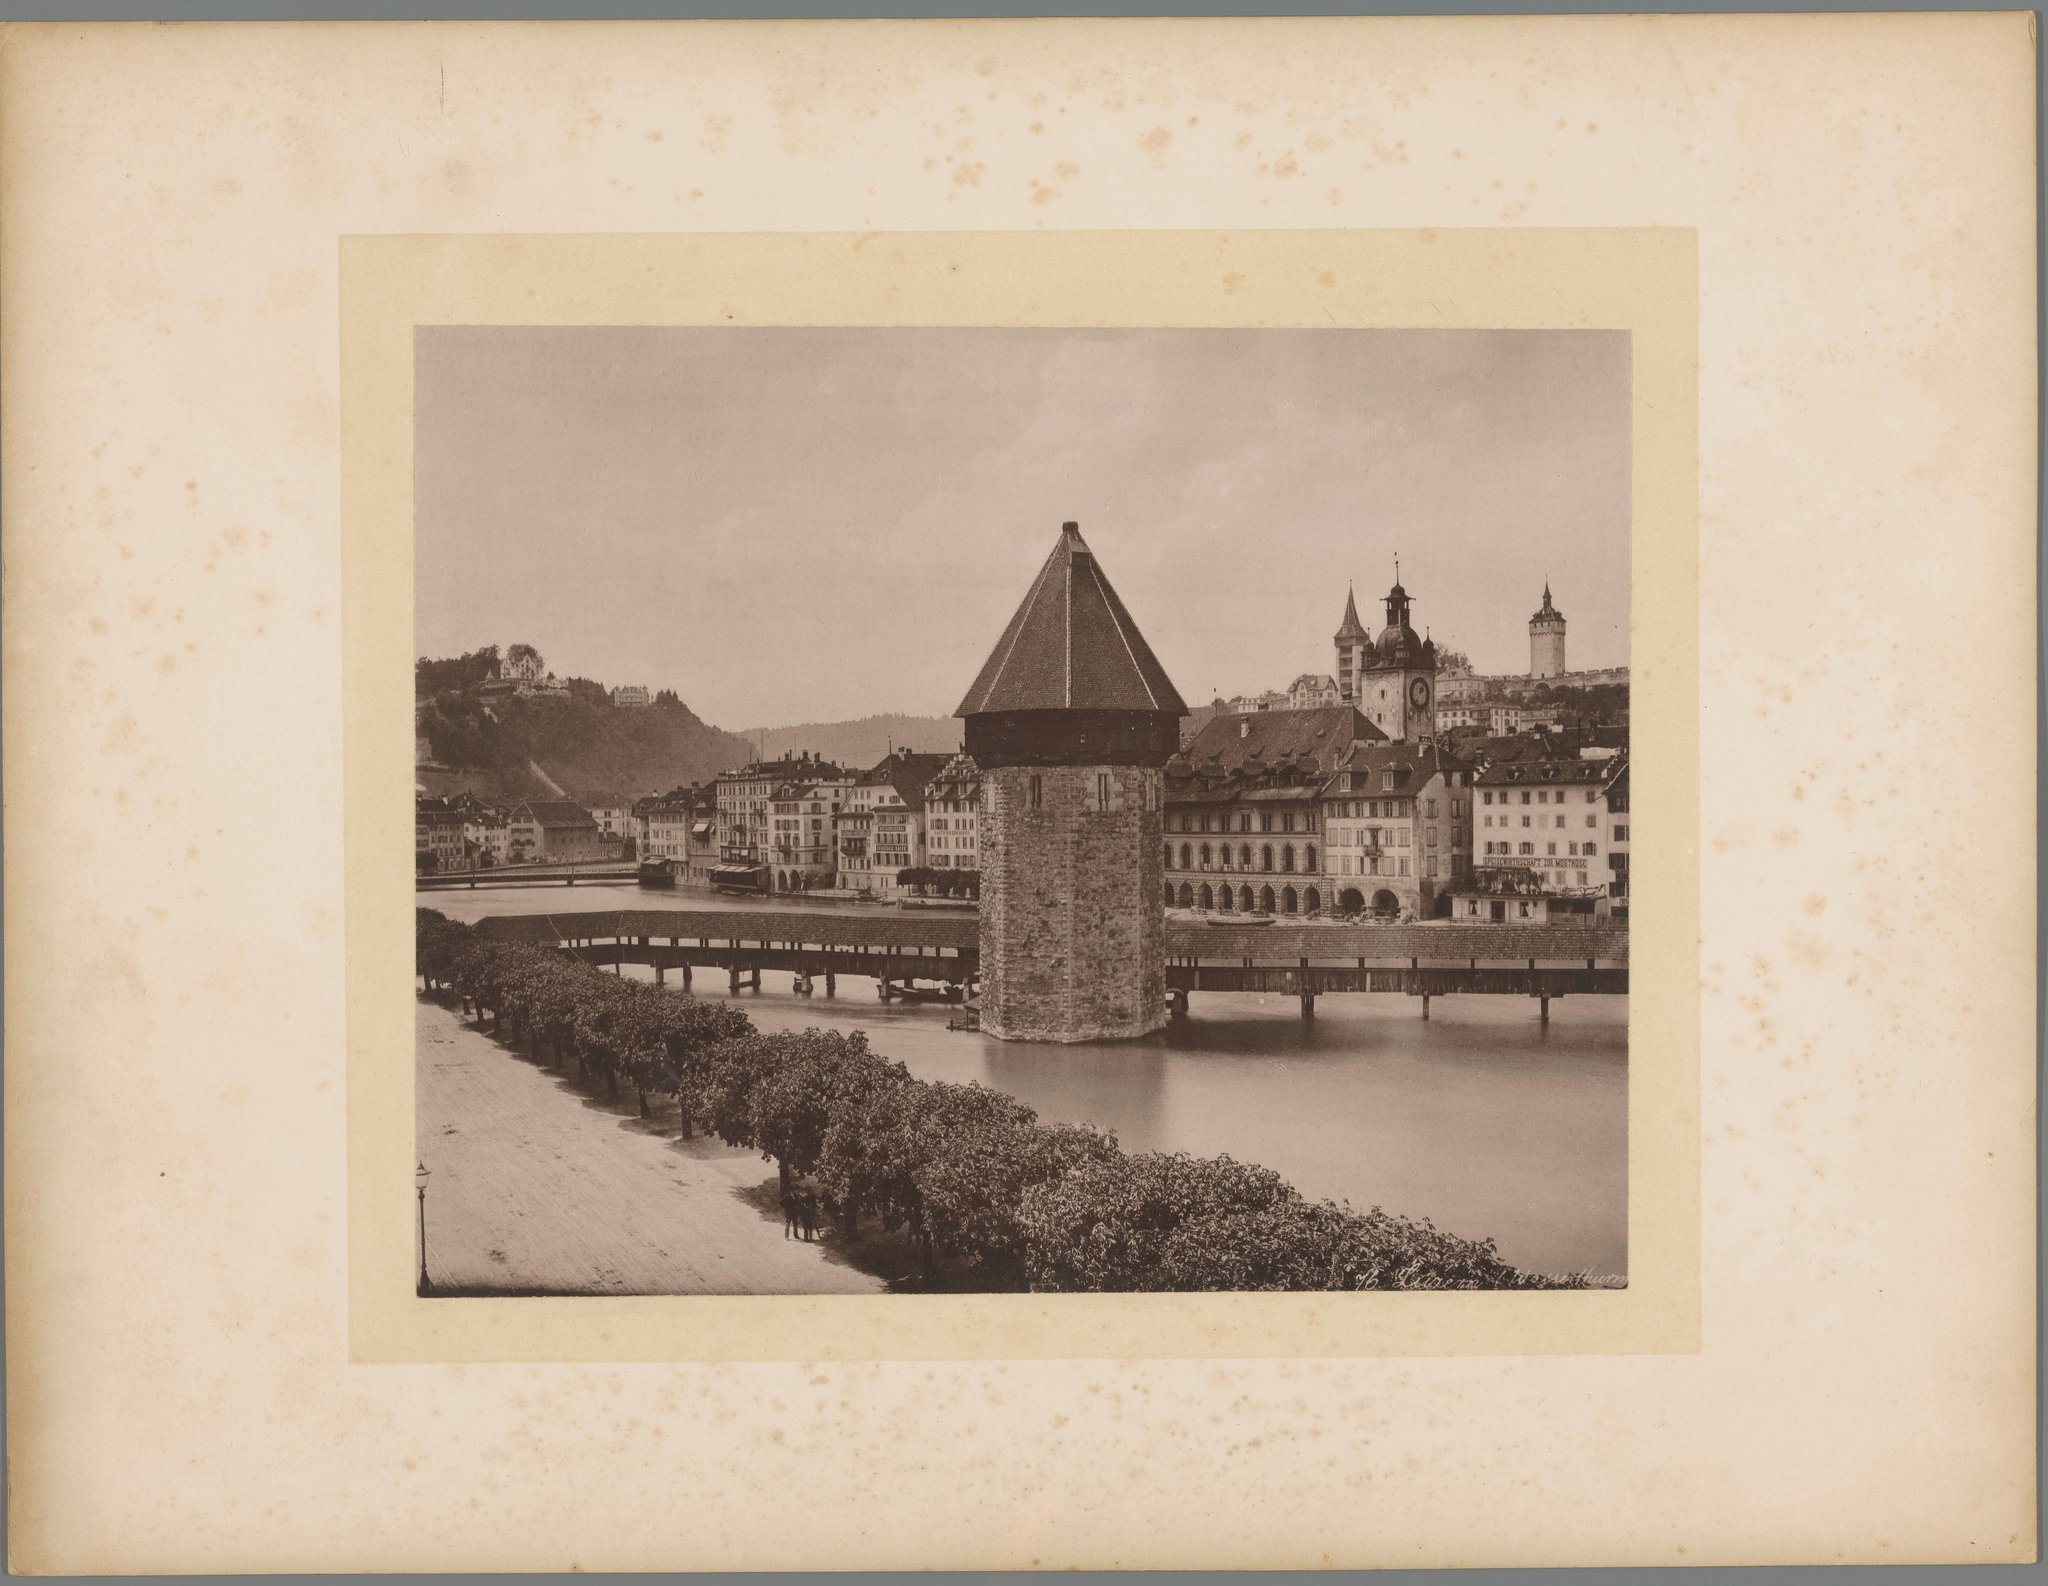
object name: photomechanical print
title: Kapelbrug in Luzern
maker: Anonymous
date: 1870-1930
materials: cardboard, paper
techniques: photograph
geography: lucerne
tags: bridge in city across river, canal, etc.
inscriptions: number: ‘76.’